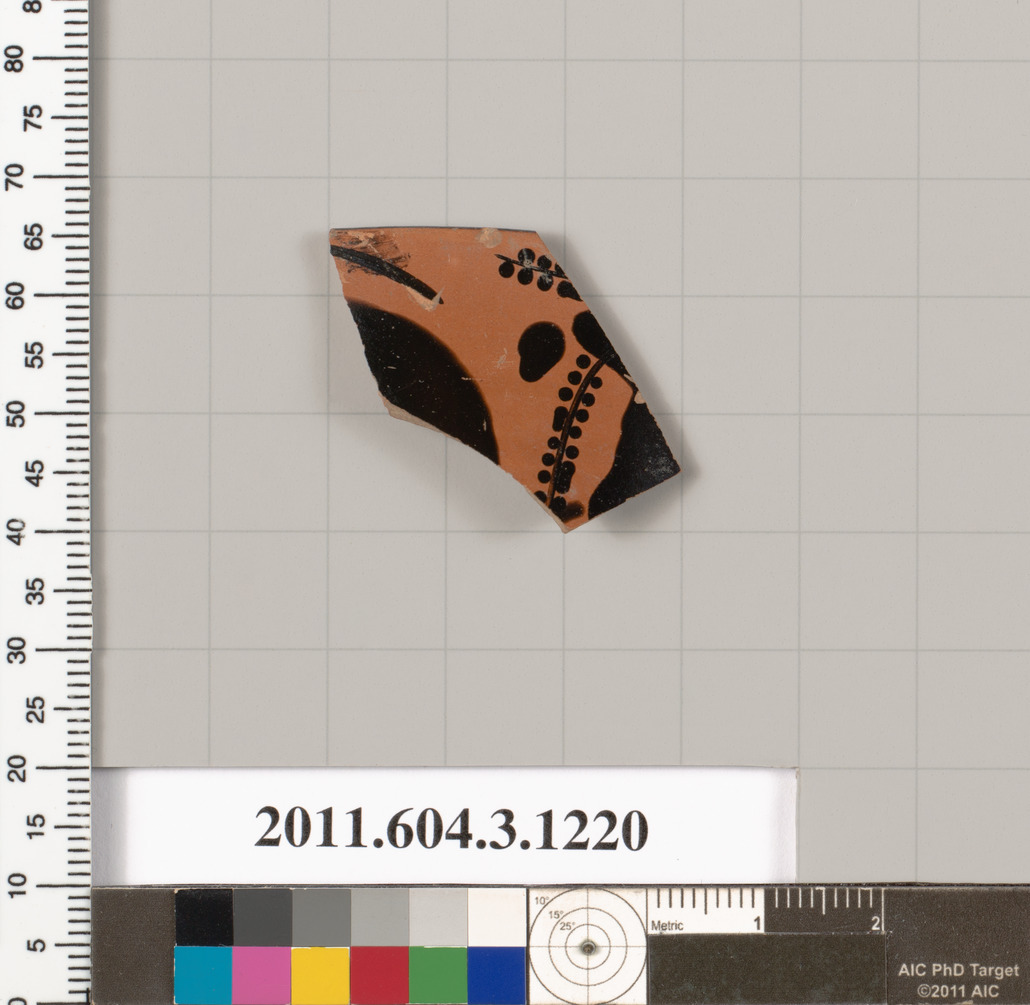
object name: kyathos fragment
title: Terracotta rim fragment of a kyathos (cup-shaped ladle)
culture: greek, attic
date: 534-468 BCE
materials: terracotta